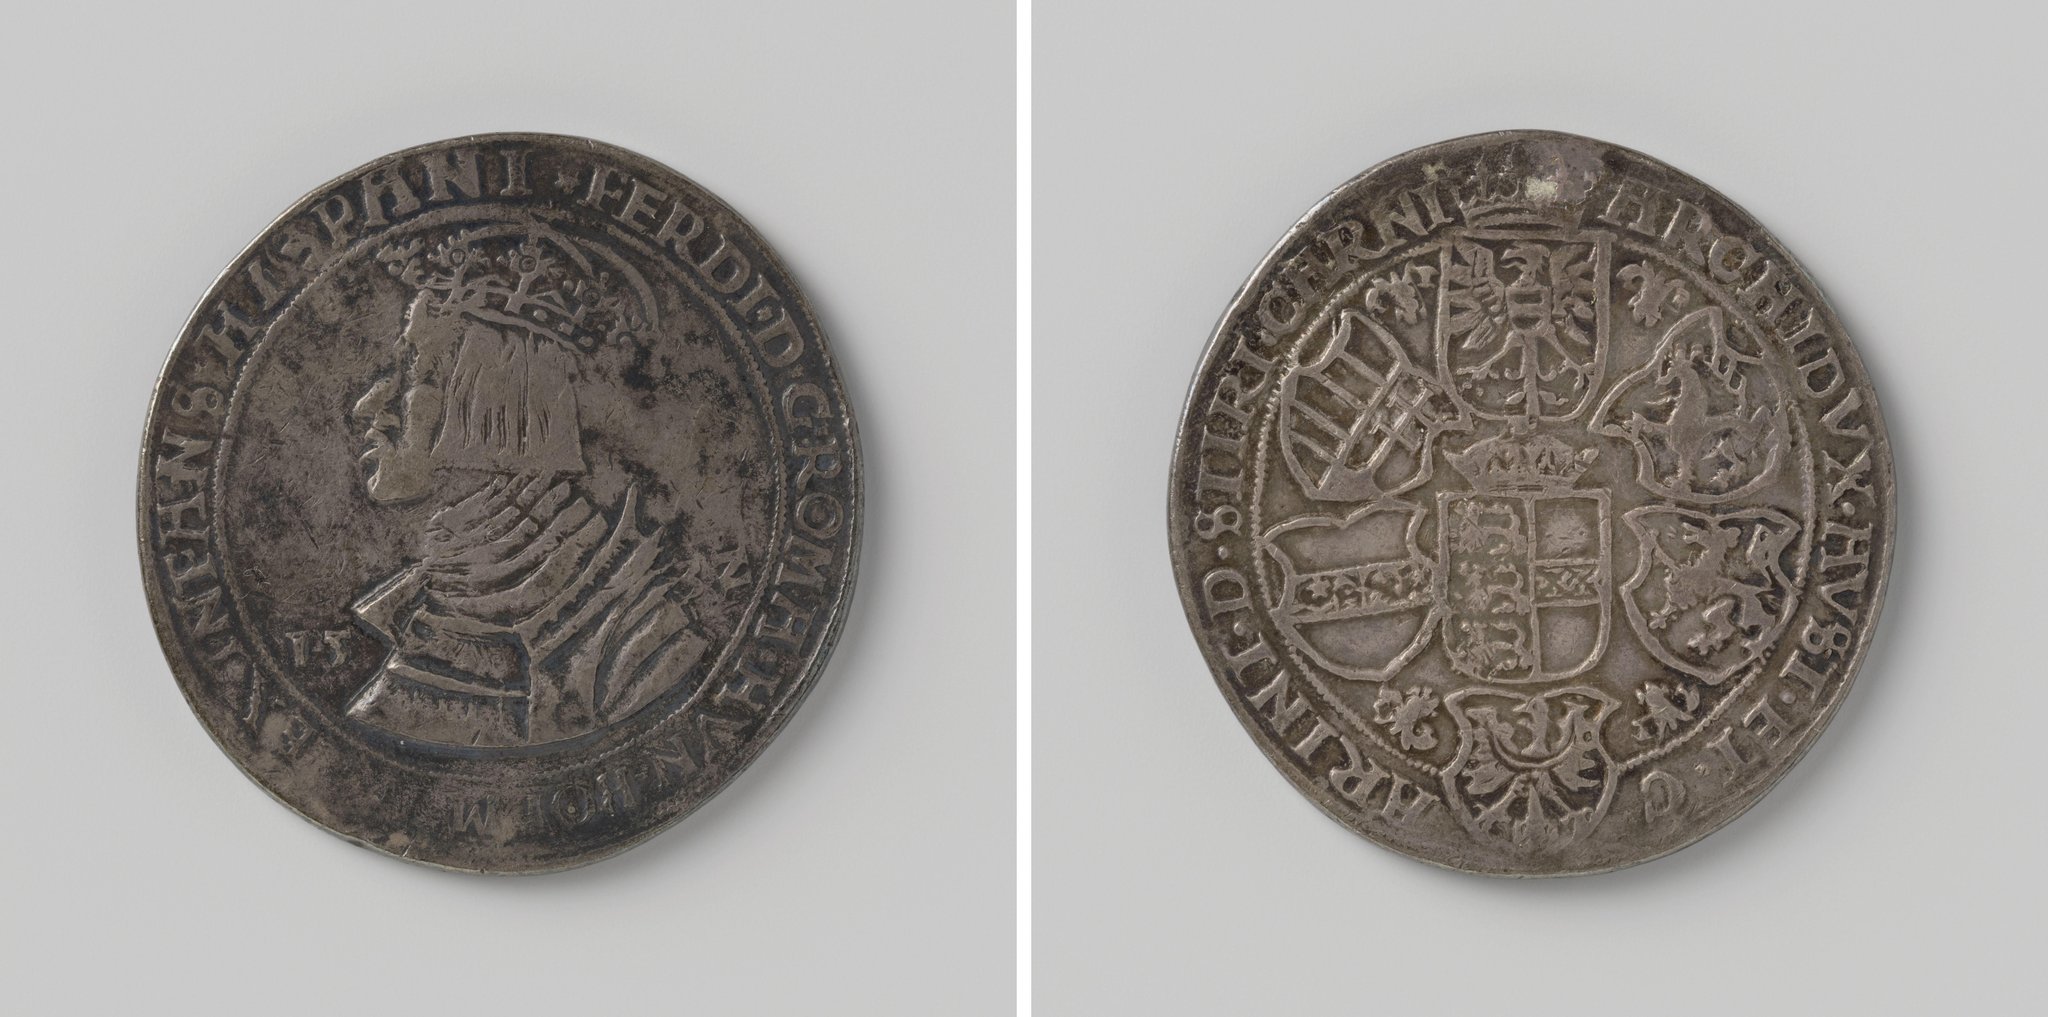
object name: history medal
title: Ferdinand I, Rooms koning en koning van Bohemen en Hongarije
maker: Anonymous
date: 1532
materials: silver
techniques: striking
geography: germany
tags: vienna, ferdinand i van habsburg (duits keizer)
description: Zilveren penning. Voorzijde: borststuk man met kroon tussen jaartal binnen omschrift. Keerzijde: gekroond wapenschild, omringd door zes wapenschilden binnen omschrift